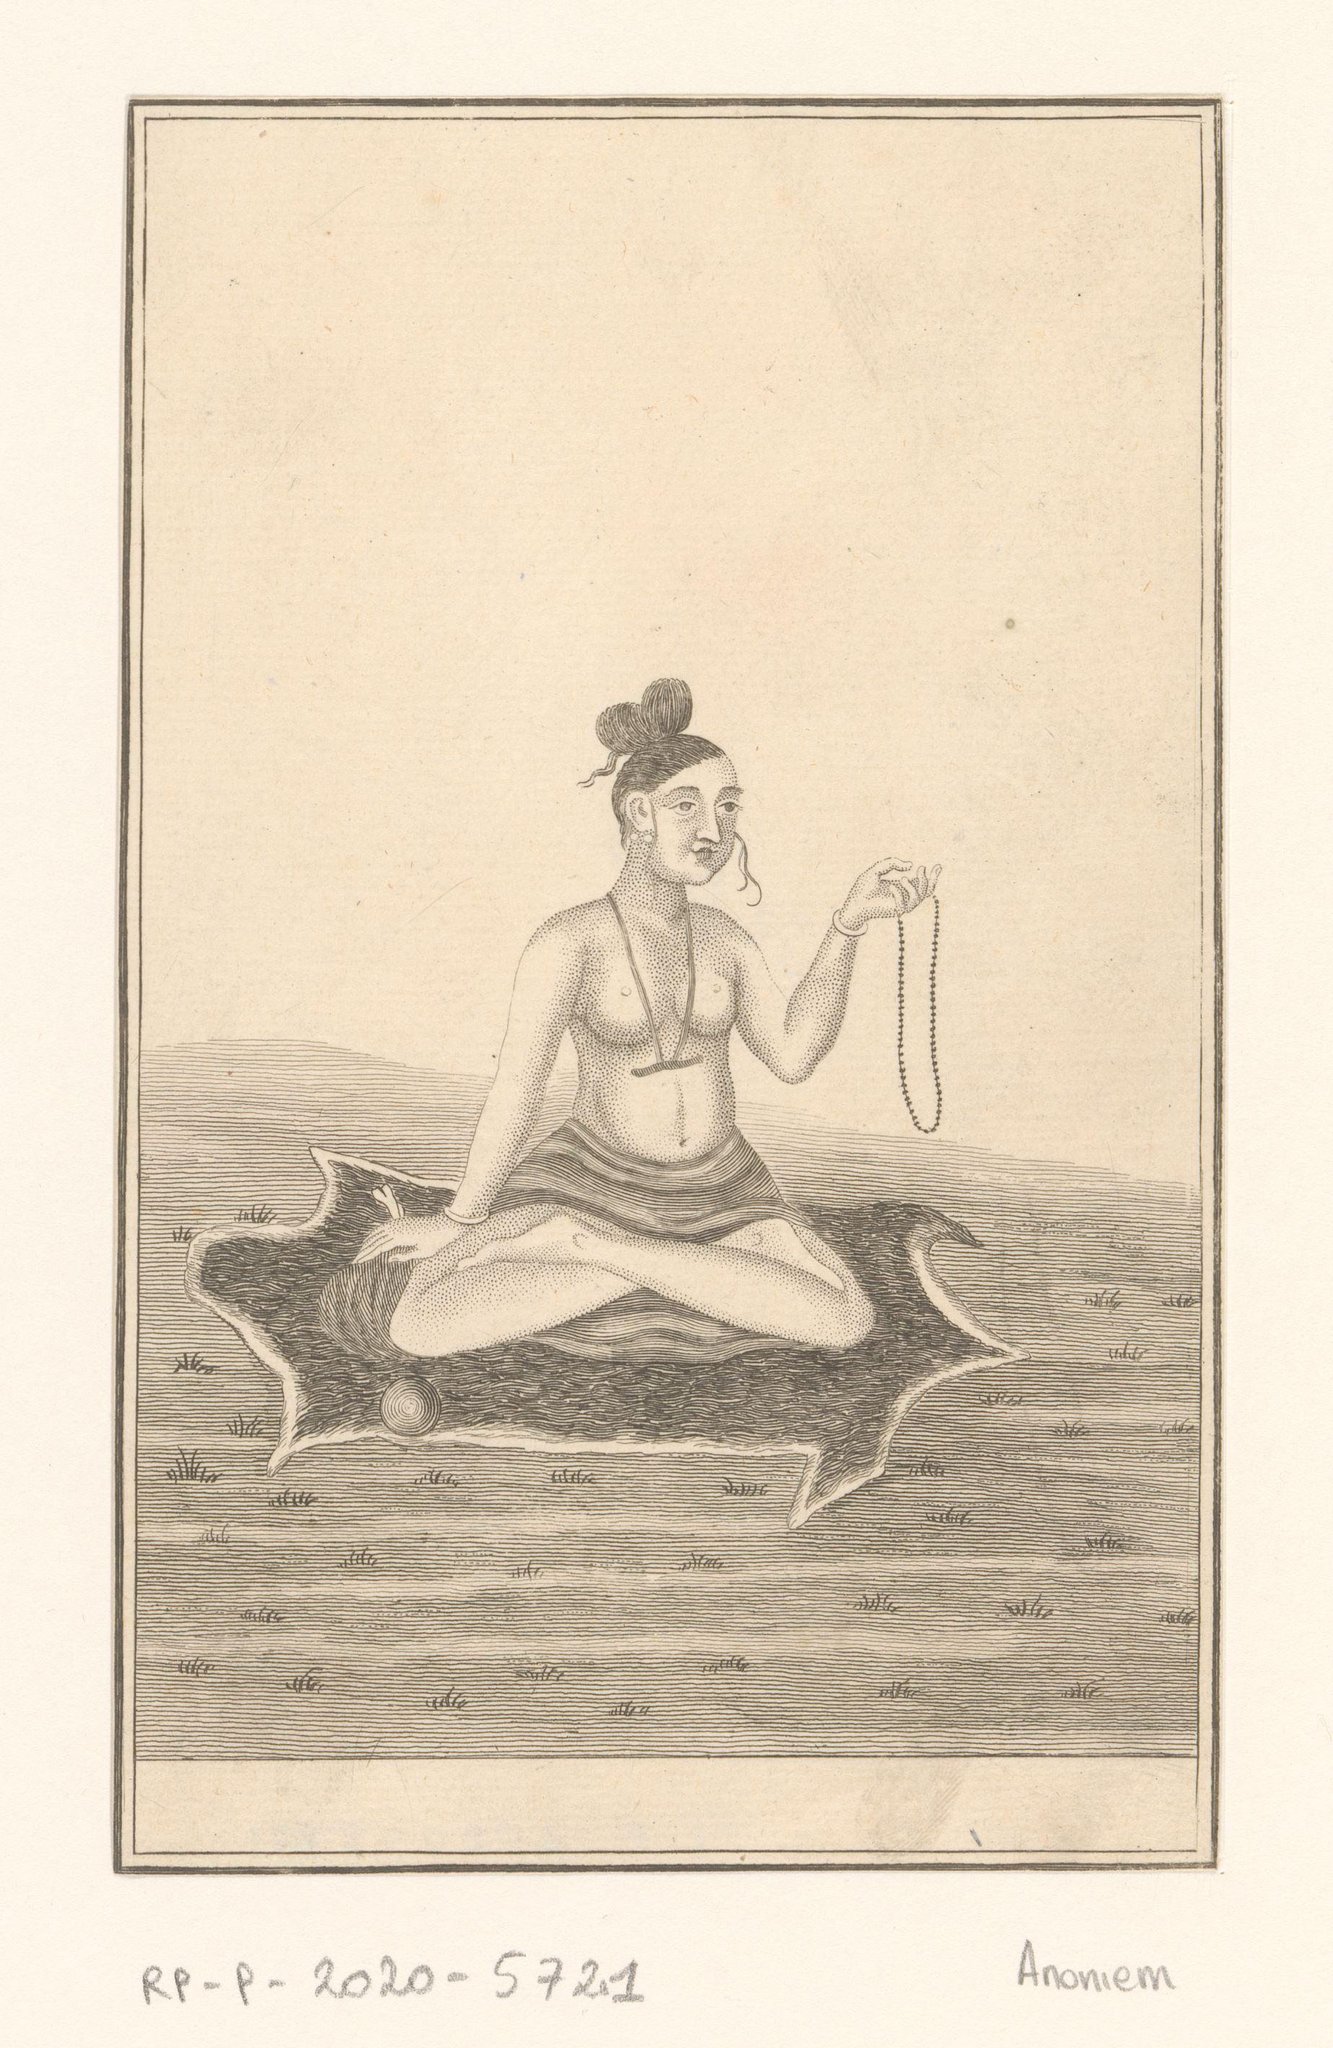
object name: print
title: Indiase vrouw in lotushouding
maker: Anonymous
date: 1750-1800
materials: paper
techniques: etching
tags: buddha-posture, 'lotus'-posture, asiatic races and peoples: indians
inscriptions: number: ‘12’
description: Vermoedelijk gemaakt naar een Indiase miniatuur.